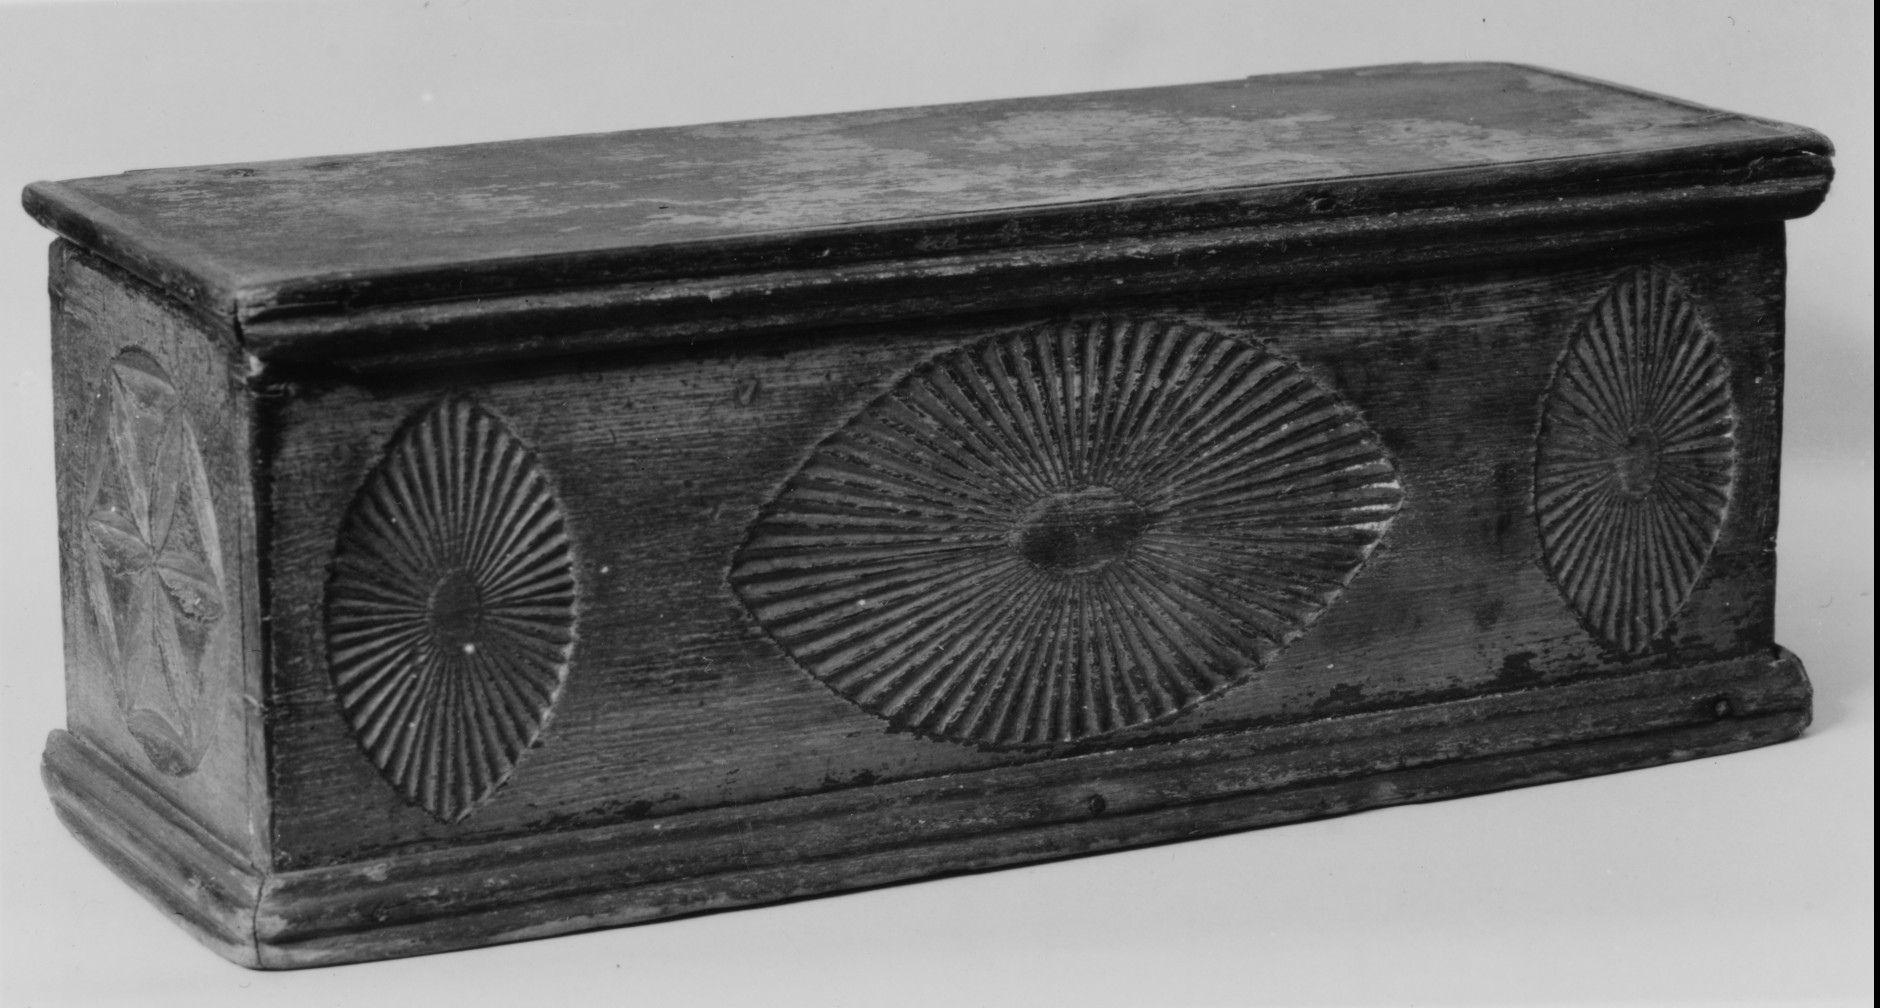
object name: box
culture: american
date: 1800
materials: brass, wood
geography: united states